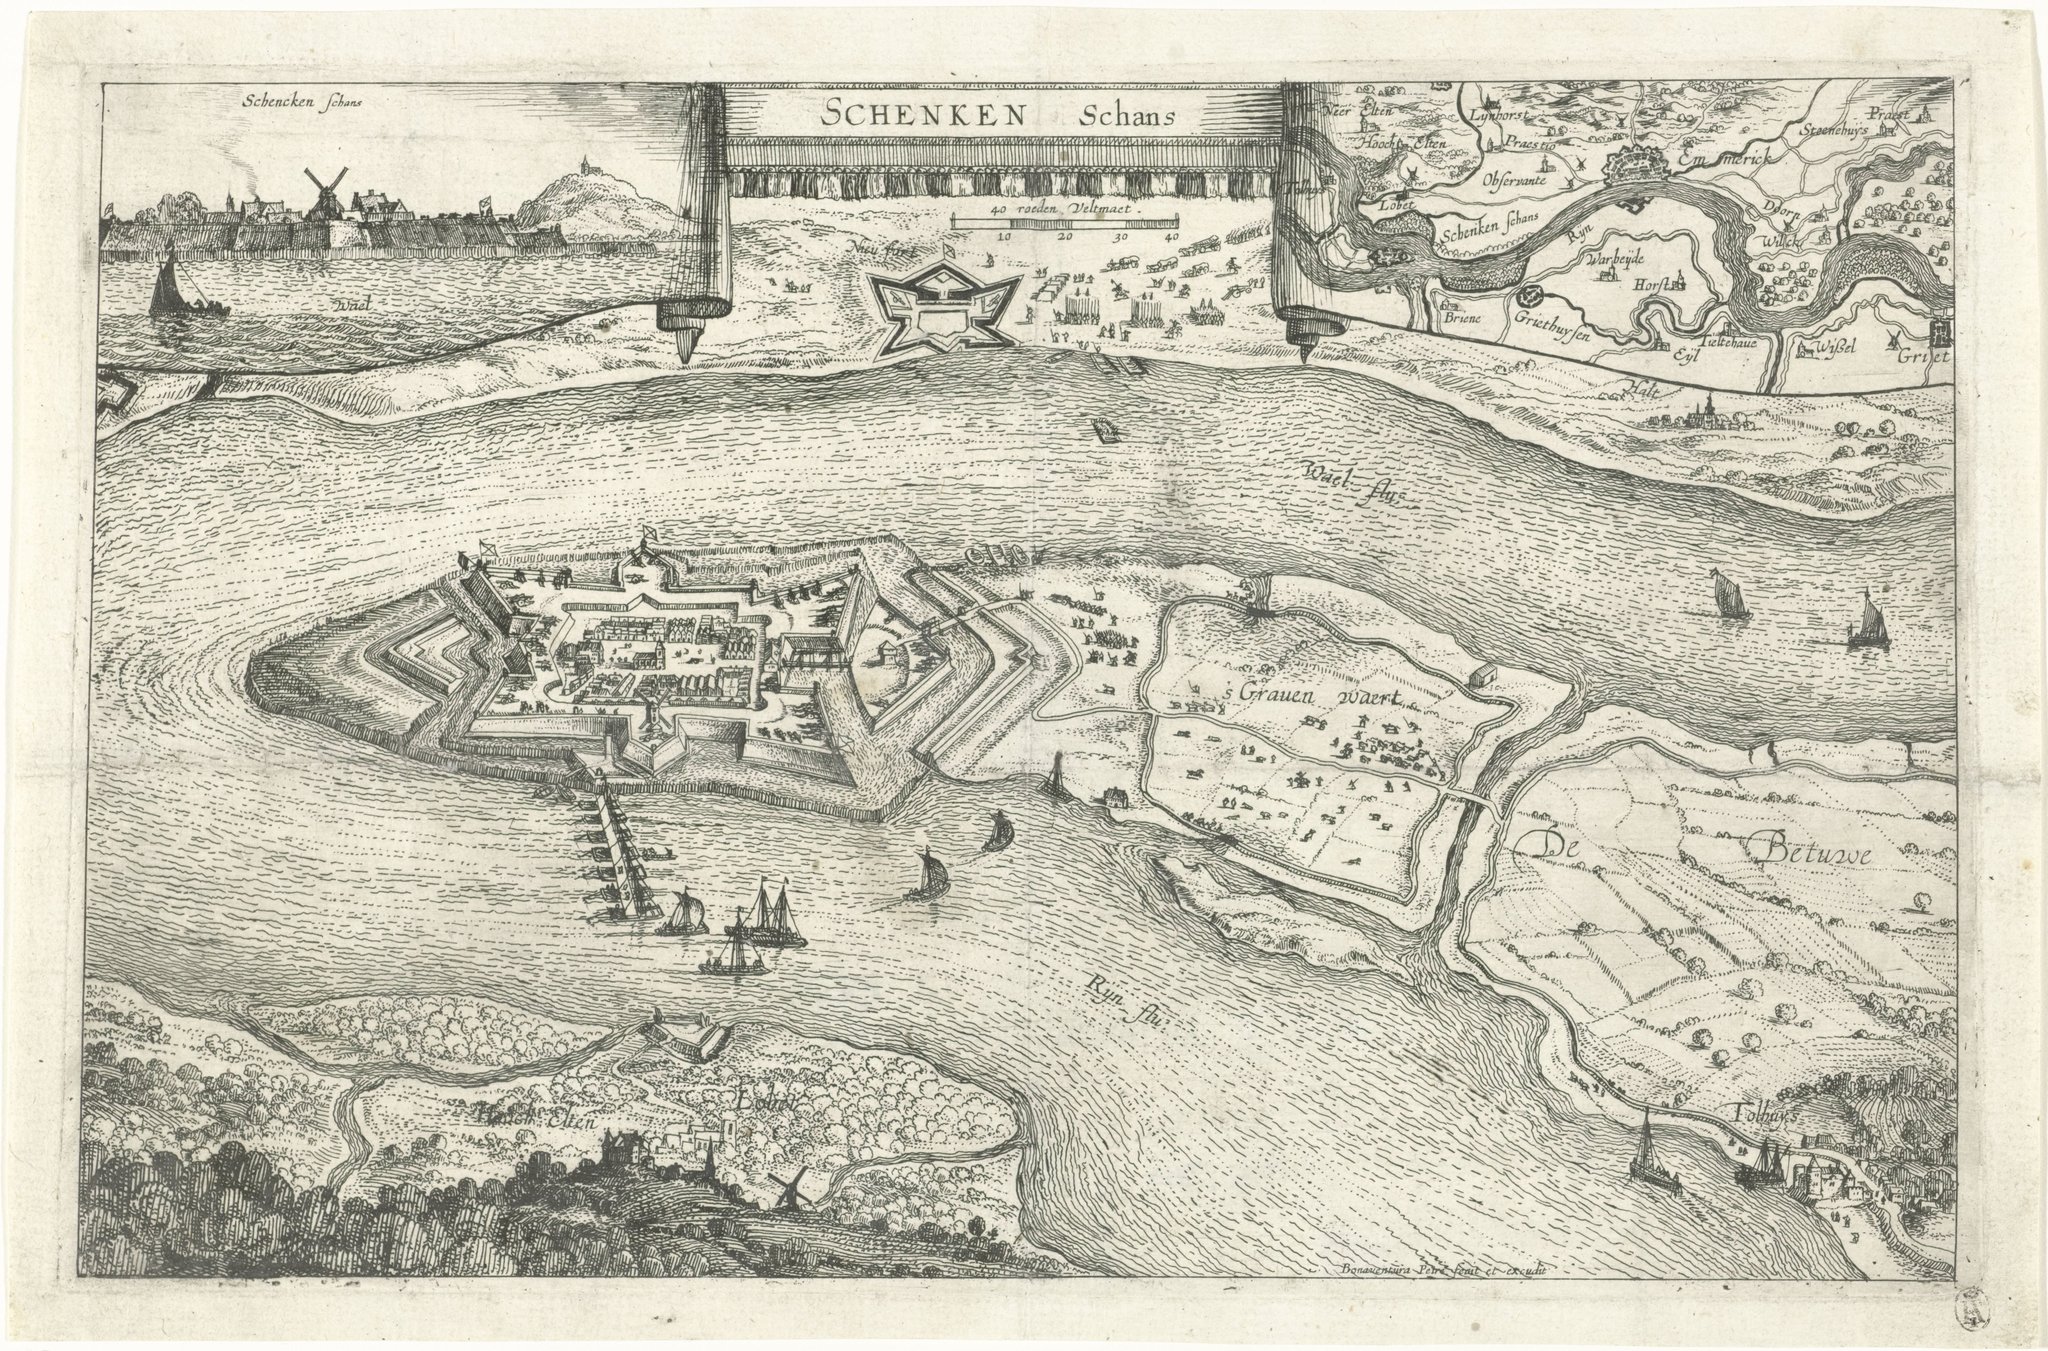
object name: print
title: Gezicht op de vesting Schenkenschans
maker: bonaventura peeters (i)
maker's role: draughtsman, painter, print maker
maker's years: 1614-1652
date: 1624-1652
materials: paper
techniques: etching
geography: antwerp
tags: schenkenschans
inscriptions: collector's mark: Lugt 2228, collector's mark: Lugt 972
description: Gezicht vanuit vogelperspectief op de vesting Schenkenschans en de omgeving. De Schenkenschans werd in 1586 door Maarten Schenk van Nydeggen aangelegd in het strategisch belangrijke gebied rond de splitsing van de rivieren Rijn en Waal. De vesting werd als 'toegangspoort' tot de Republiek der Zeven Verenigde Nederlanden en lange tijd als onneembaar gezien.